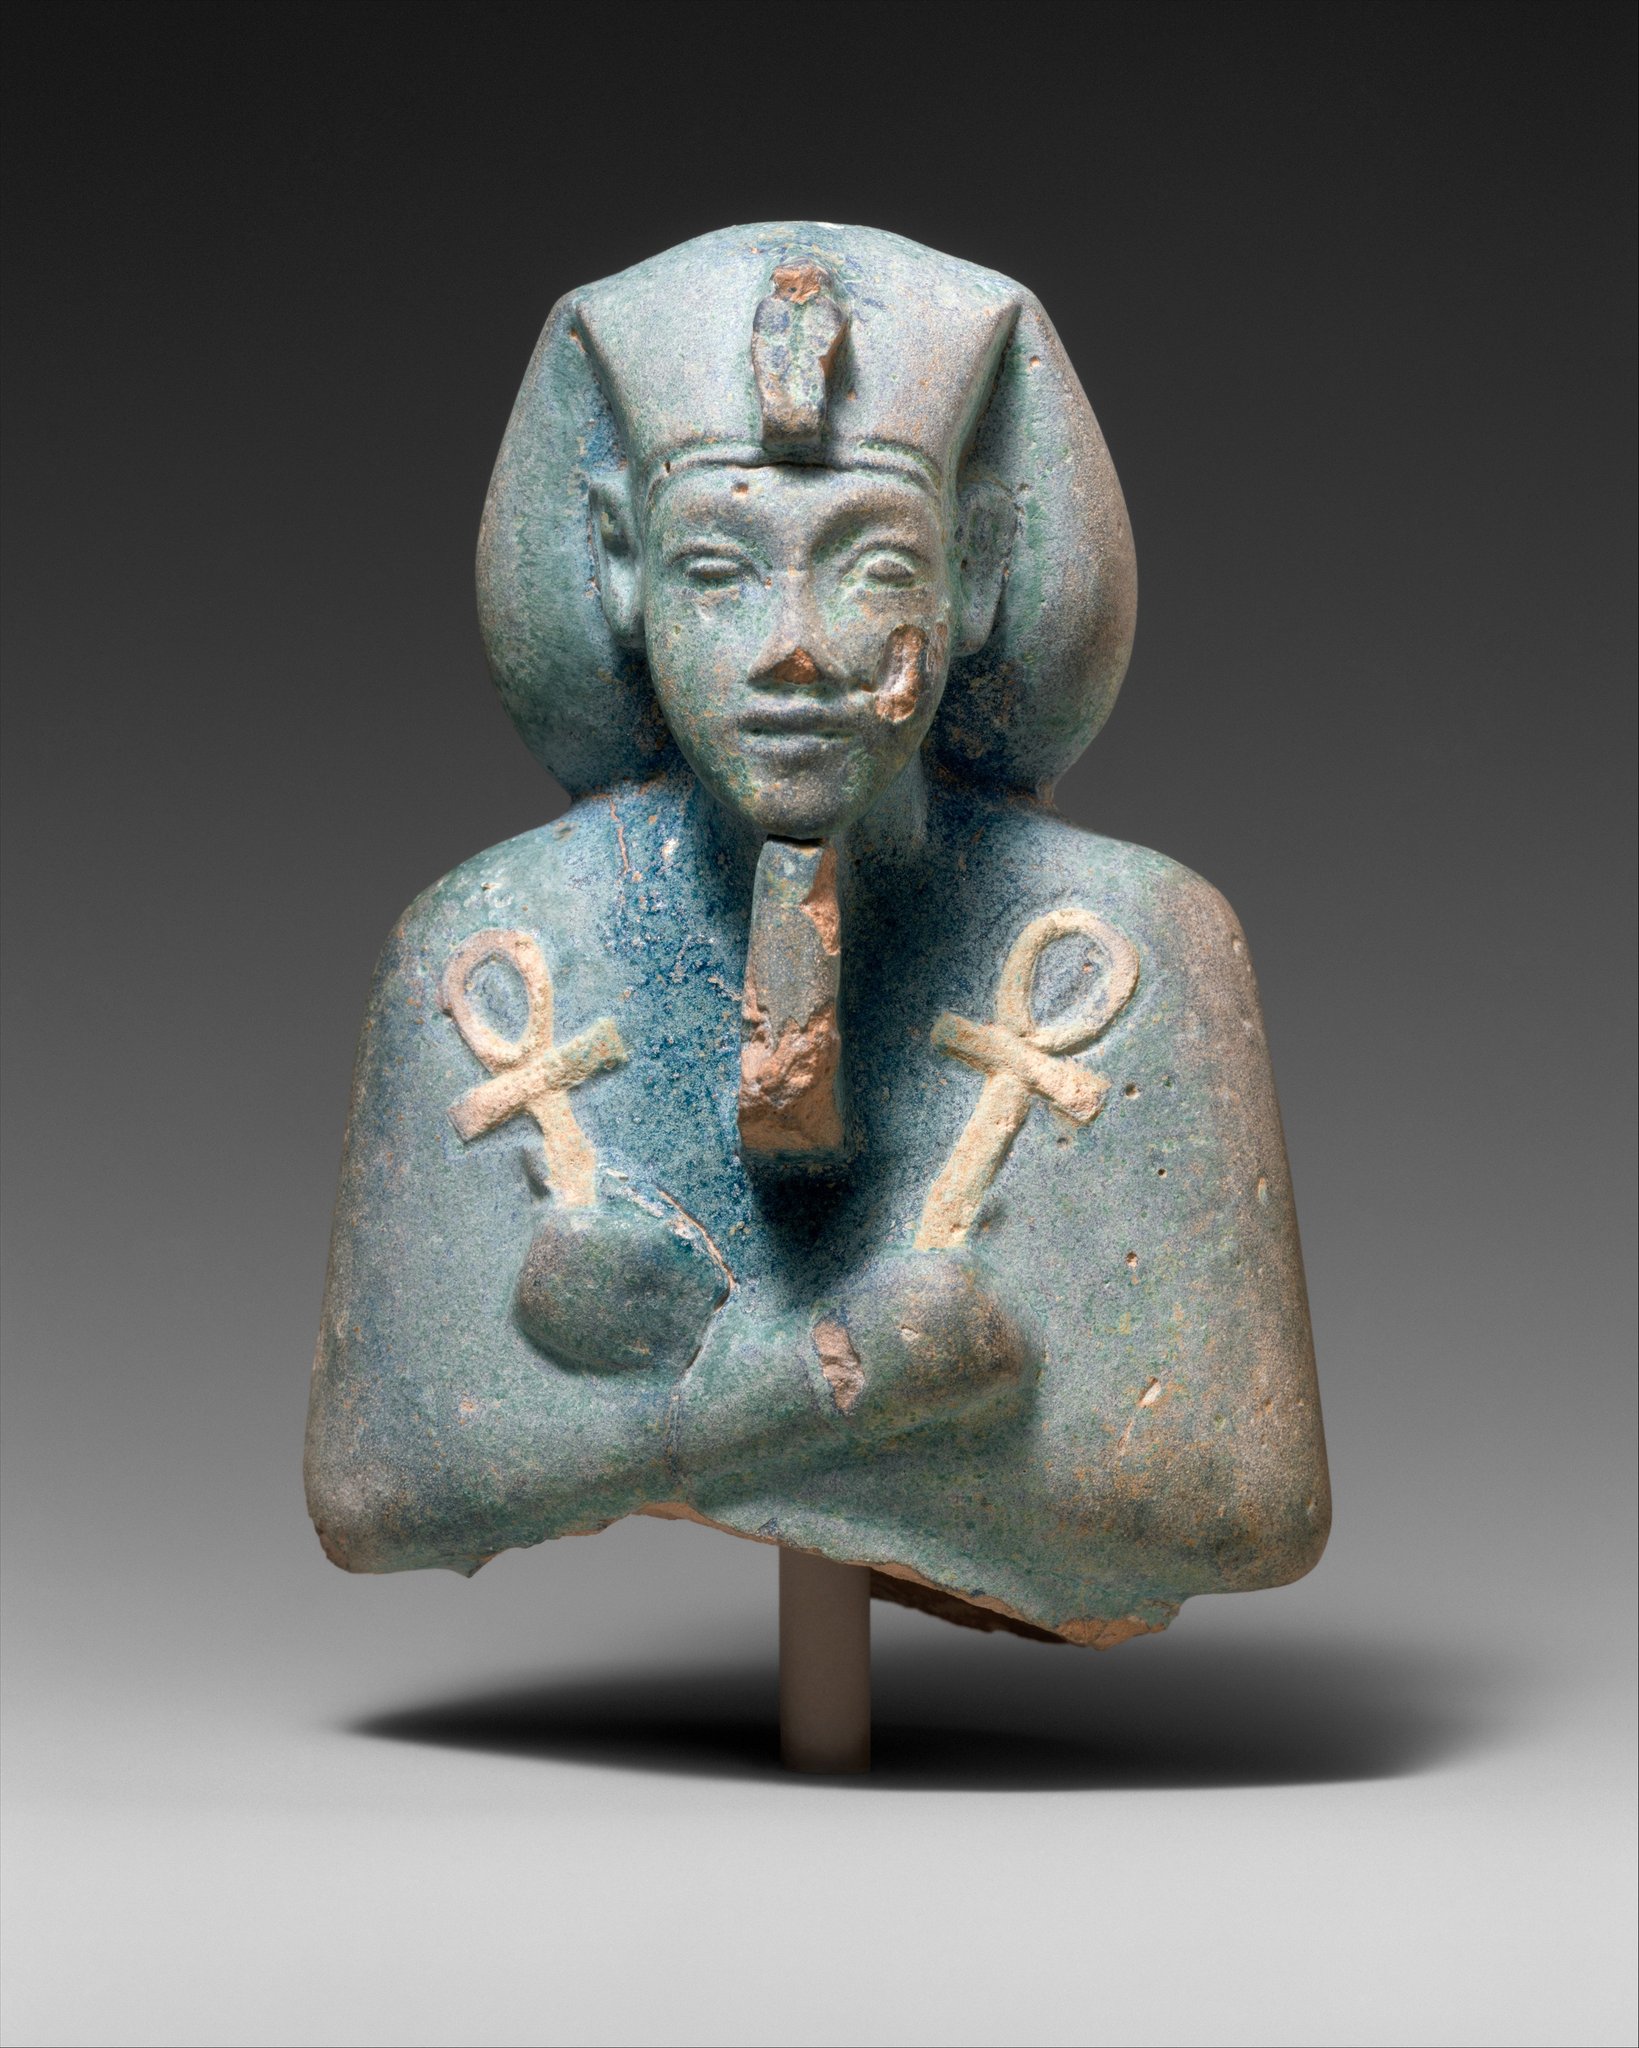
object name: shabti, akhenaten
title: Shabti of Akhenaten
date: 1353-1336 BCE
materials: faience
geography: middle egypt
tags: kings